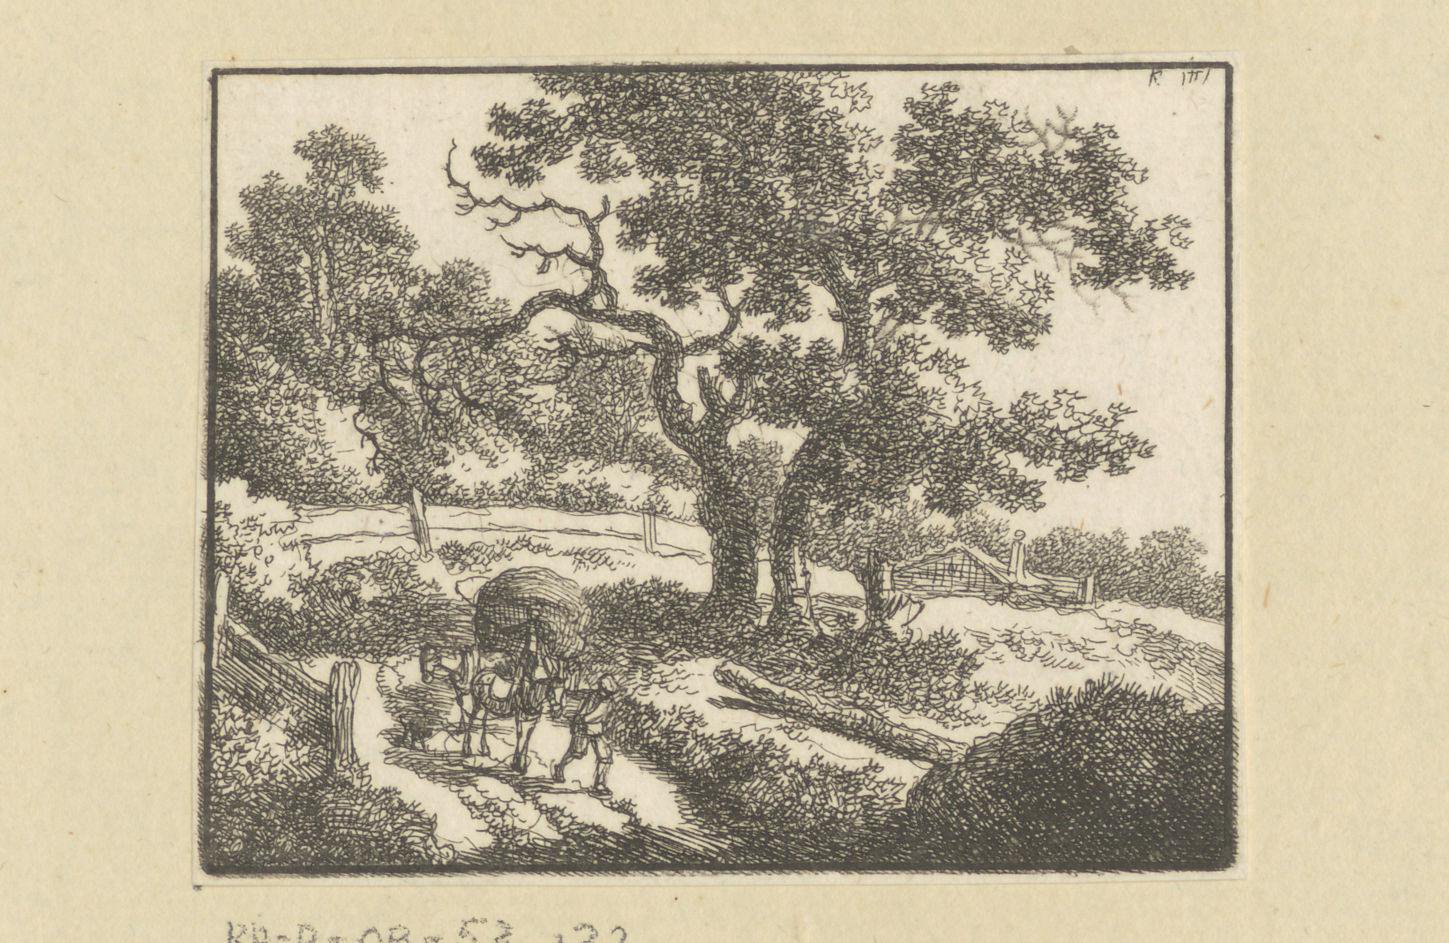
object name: print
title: Landschap met een boer en een beladen kar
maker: johann christian klengel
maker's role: print maker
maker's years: 1751-1824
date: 1771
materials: paper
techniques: etching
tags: forest path or lane, (farm) wagon, freight wagon, cart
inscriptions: collector's mark: Lugt 240